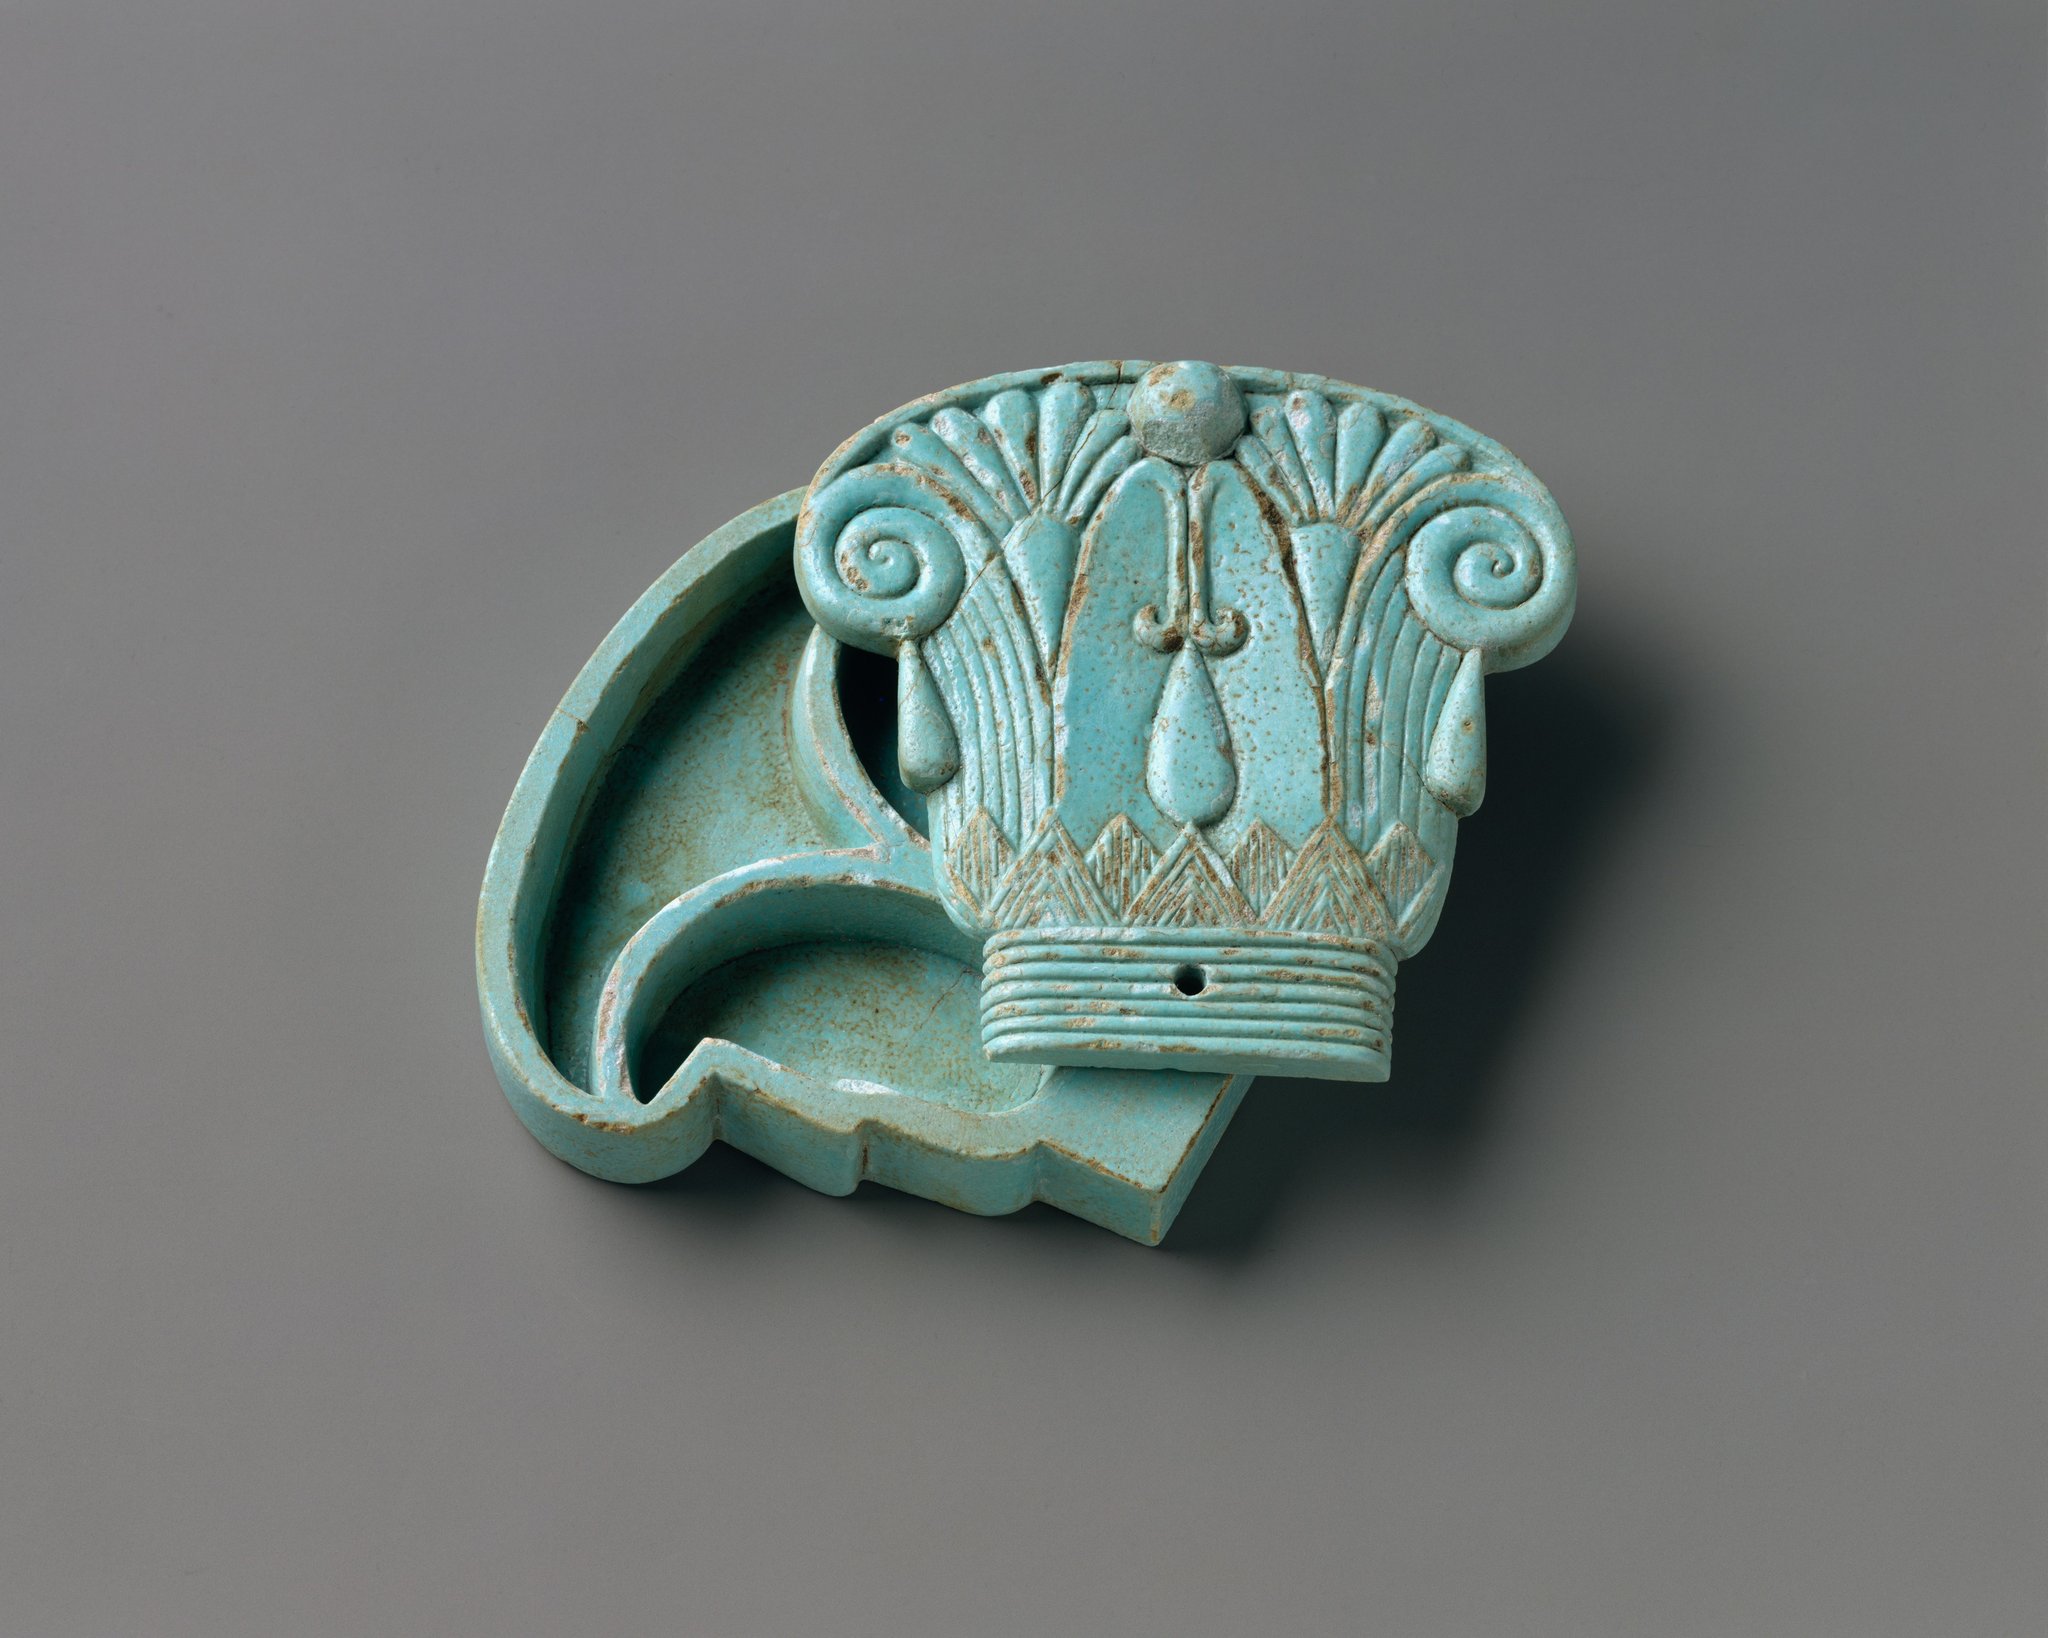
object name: cosmetic box, swivel lid, composite capital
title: Cosmetic box in the shape of a composite capital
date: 664-300 BCE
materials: faience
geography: egypt